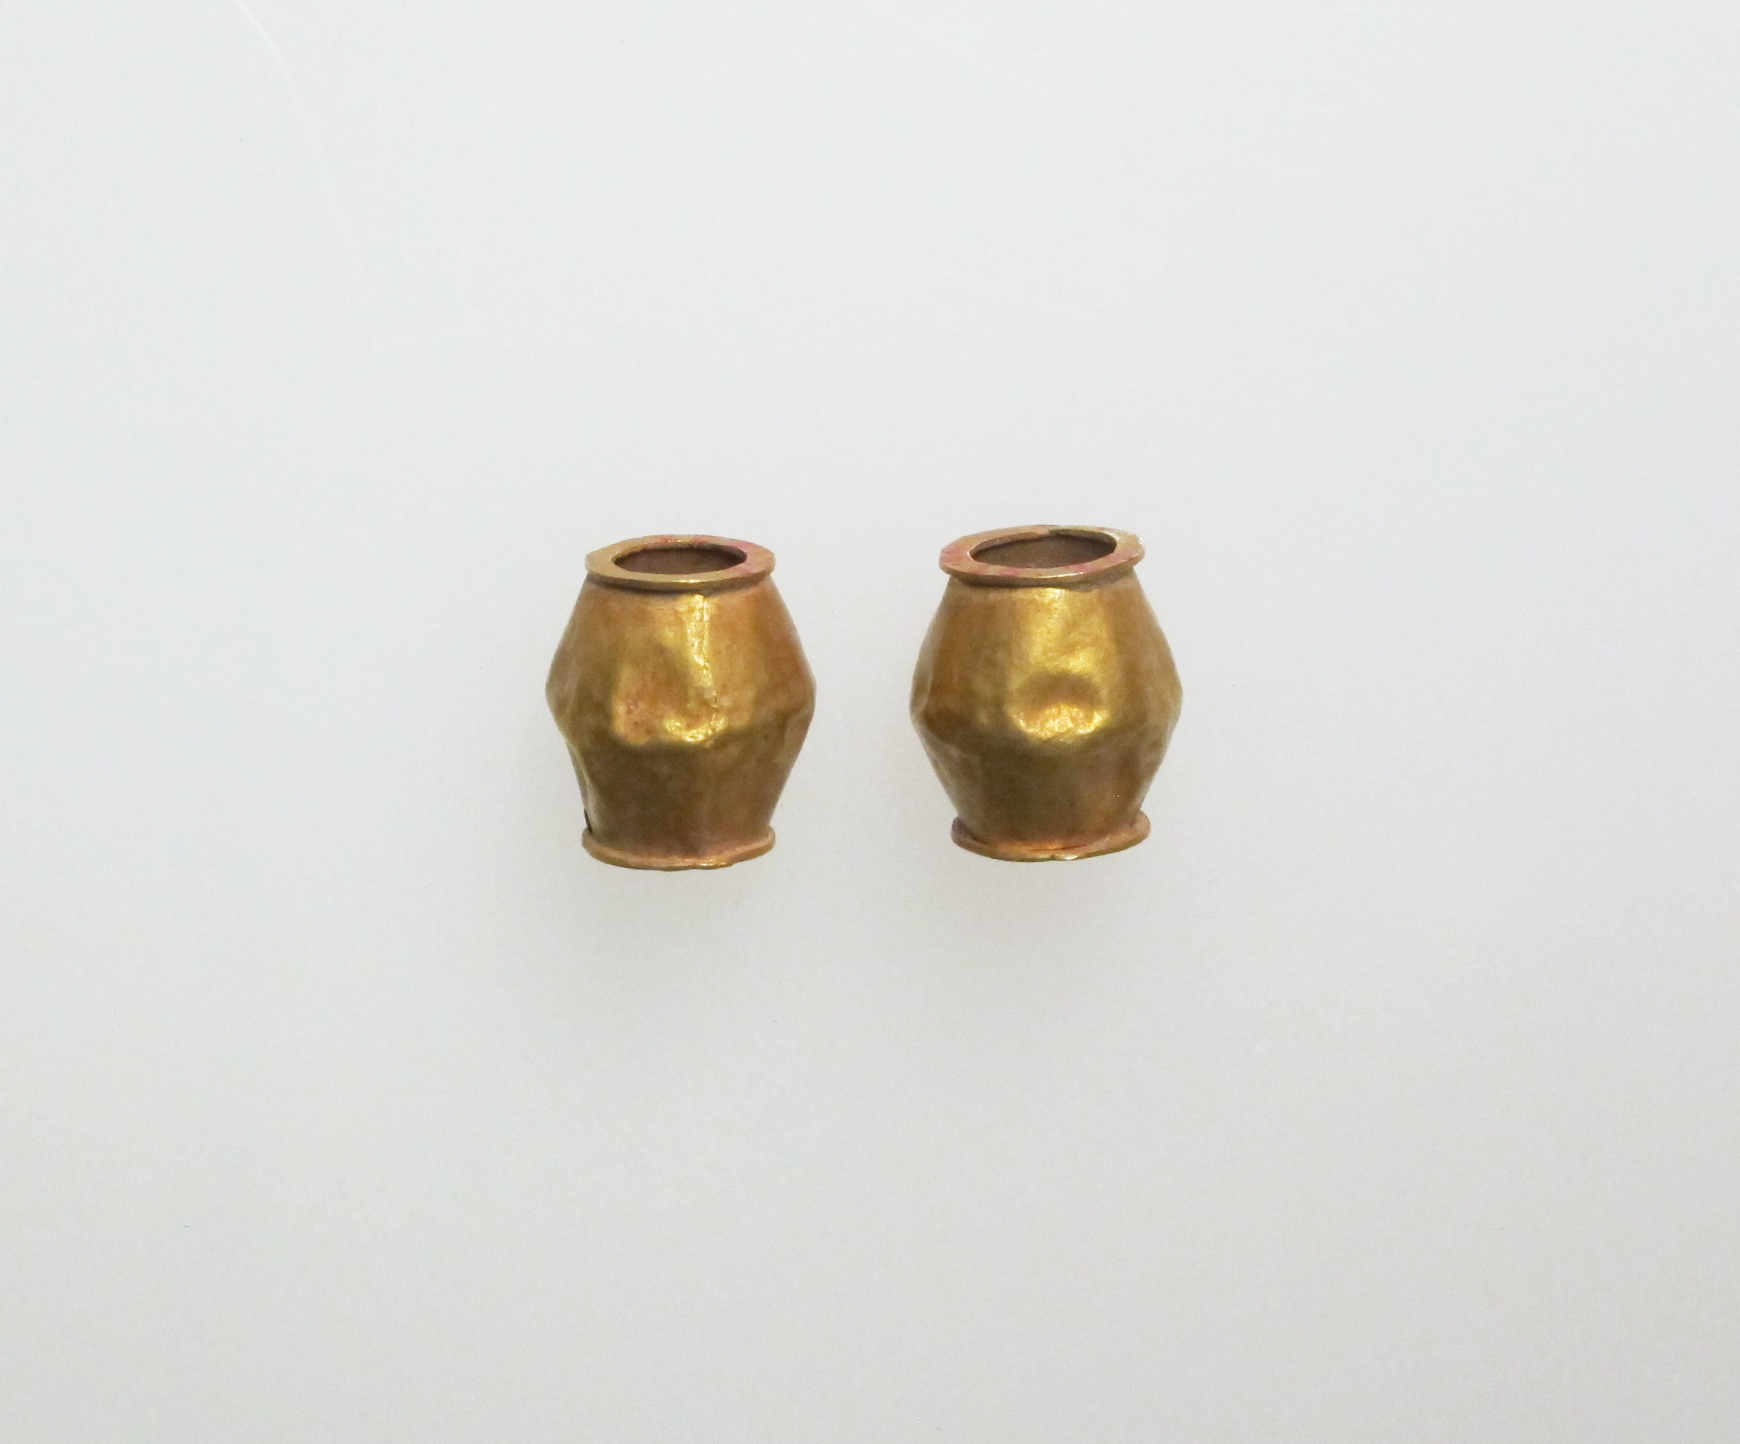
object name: bead, control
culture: greek or roman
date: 7000 BCE-330 CE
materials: gold